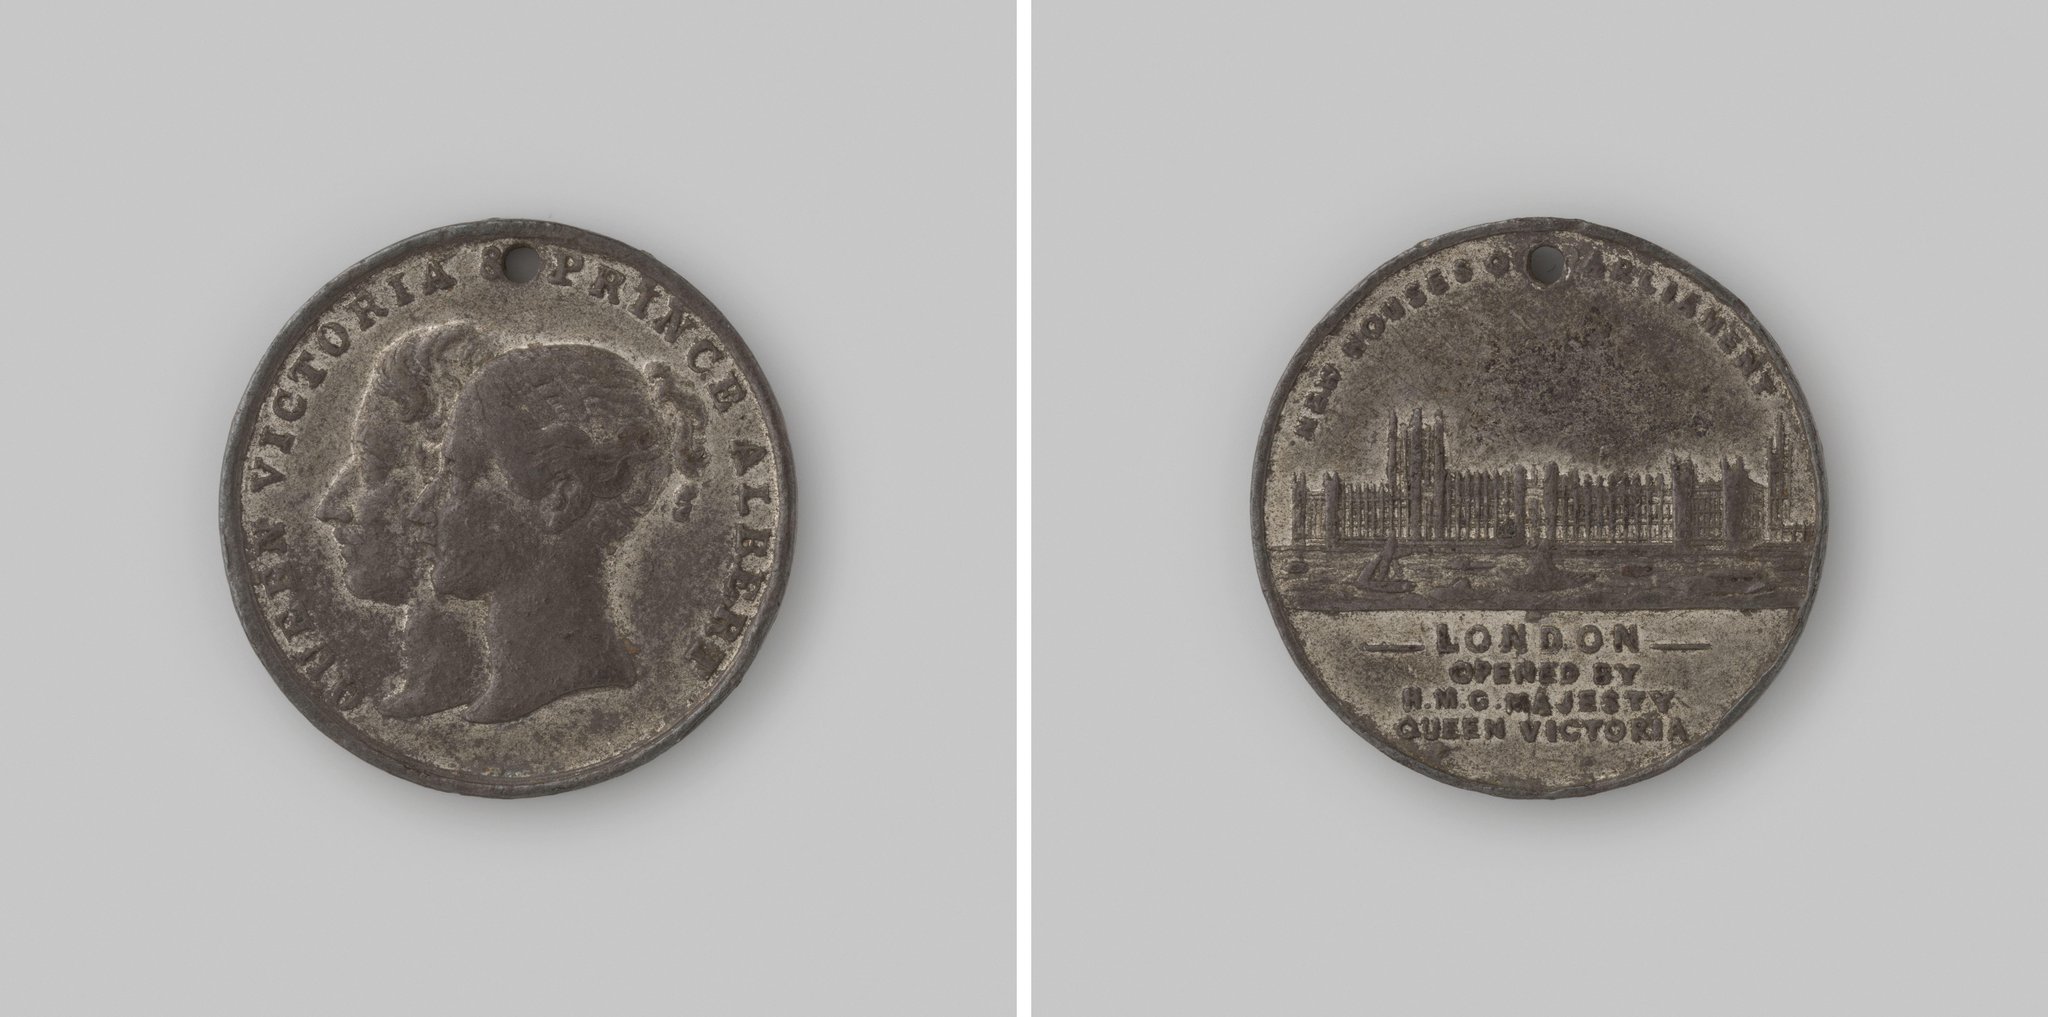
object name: history medal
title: Opening van de Parlementsgebouwen te Londen 1847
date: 1837-1847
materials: tin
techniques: striking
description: Tinnen penning met doorboring, op de voorzijde de geconjugeerde portretten van Albert en Victoria naar links met omschrift, op de keerzijde het aanzicht van de Parlementsgebouwen met omschrift en afsnedetekst.